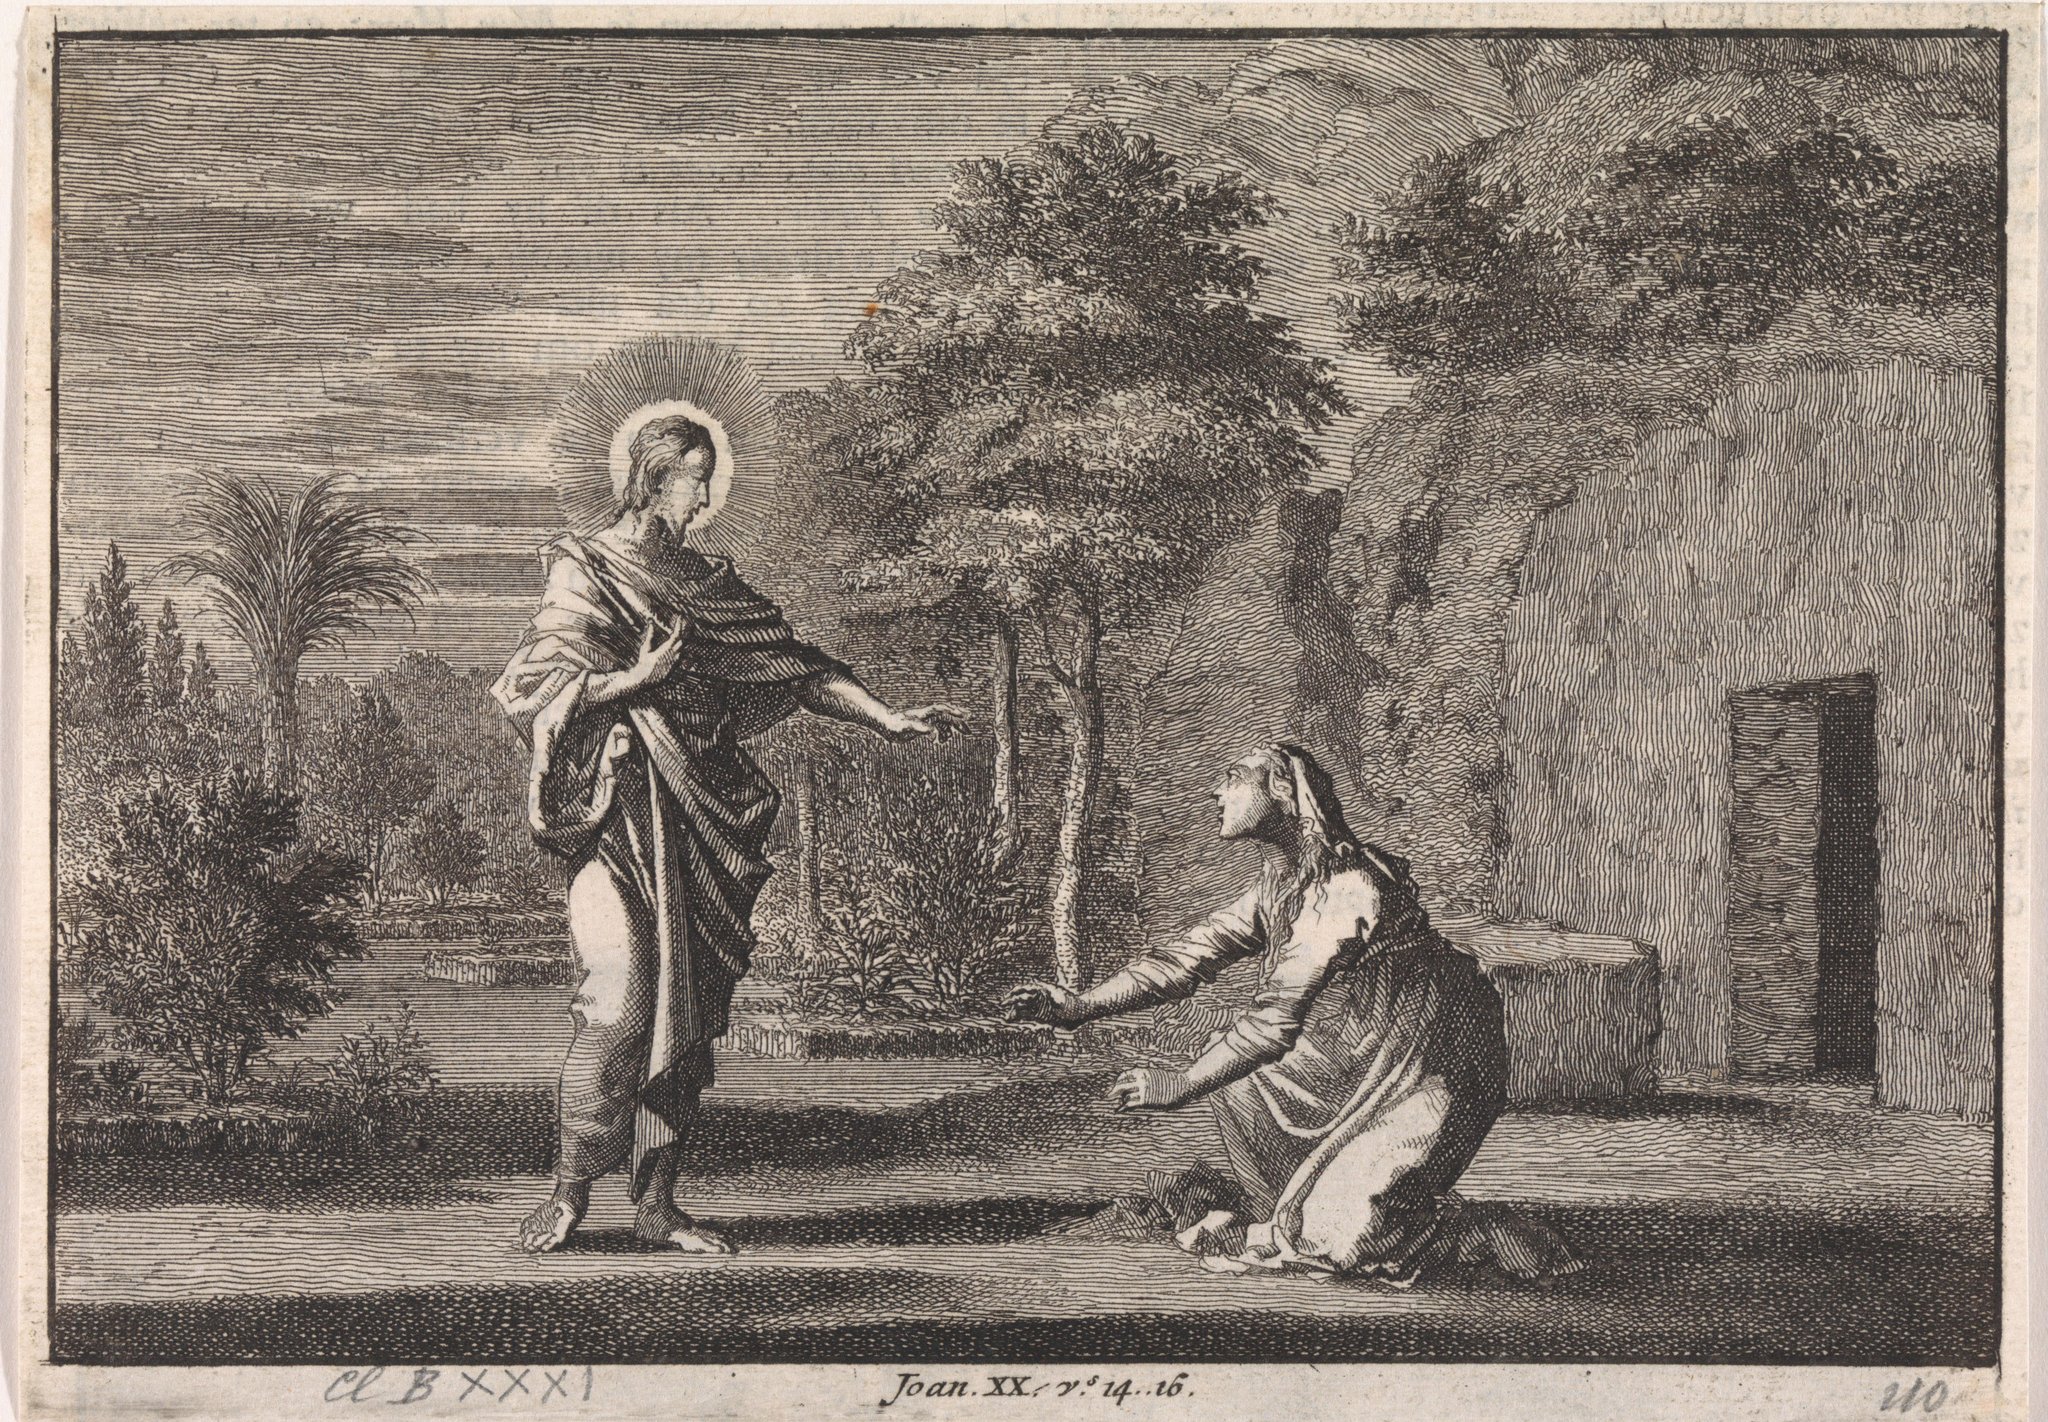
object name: print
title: Christus verschijnt aan Maria Magdalena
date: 1703-1762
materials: paper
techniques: etching, letterpress printing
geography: amsterdam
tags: mary magdalene kneeling before christ, who is usually represented as a gardener with a hoe and/or a spade; 'noli me tangere'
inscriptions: collector's mark: Lugt 2228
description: De prent komt een eerste keer voor als boekillustratie voor David Martin. Historie des Ouden en Nieuwen Testaments. Amsterdam, Pieter Mortier, 1703. Deel II. De boekillustraties voor de Mortierbijbel hebben verschillende staten en kopieën, waarbij de chronologische volgorde moeilijk te achterhalen valt. Als boekillustraties werden ze bovendien herhaaldelijk opnieuw gebruikt voor andere boekwerken.